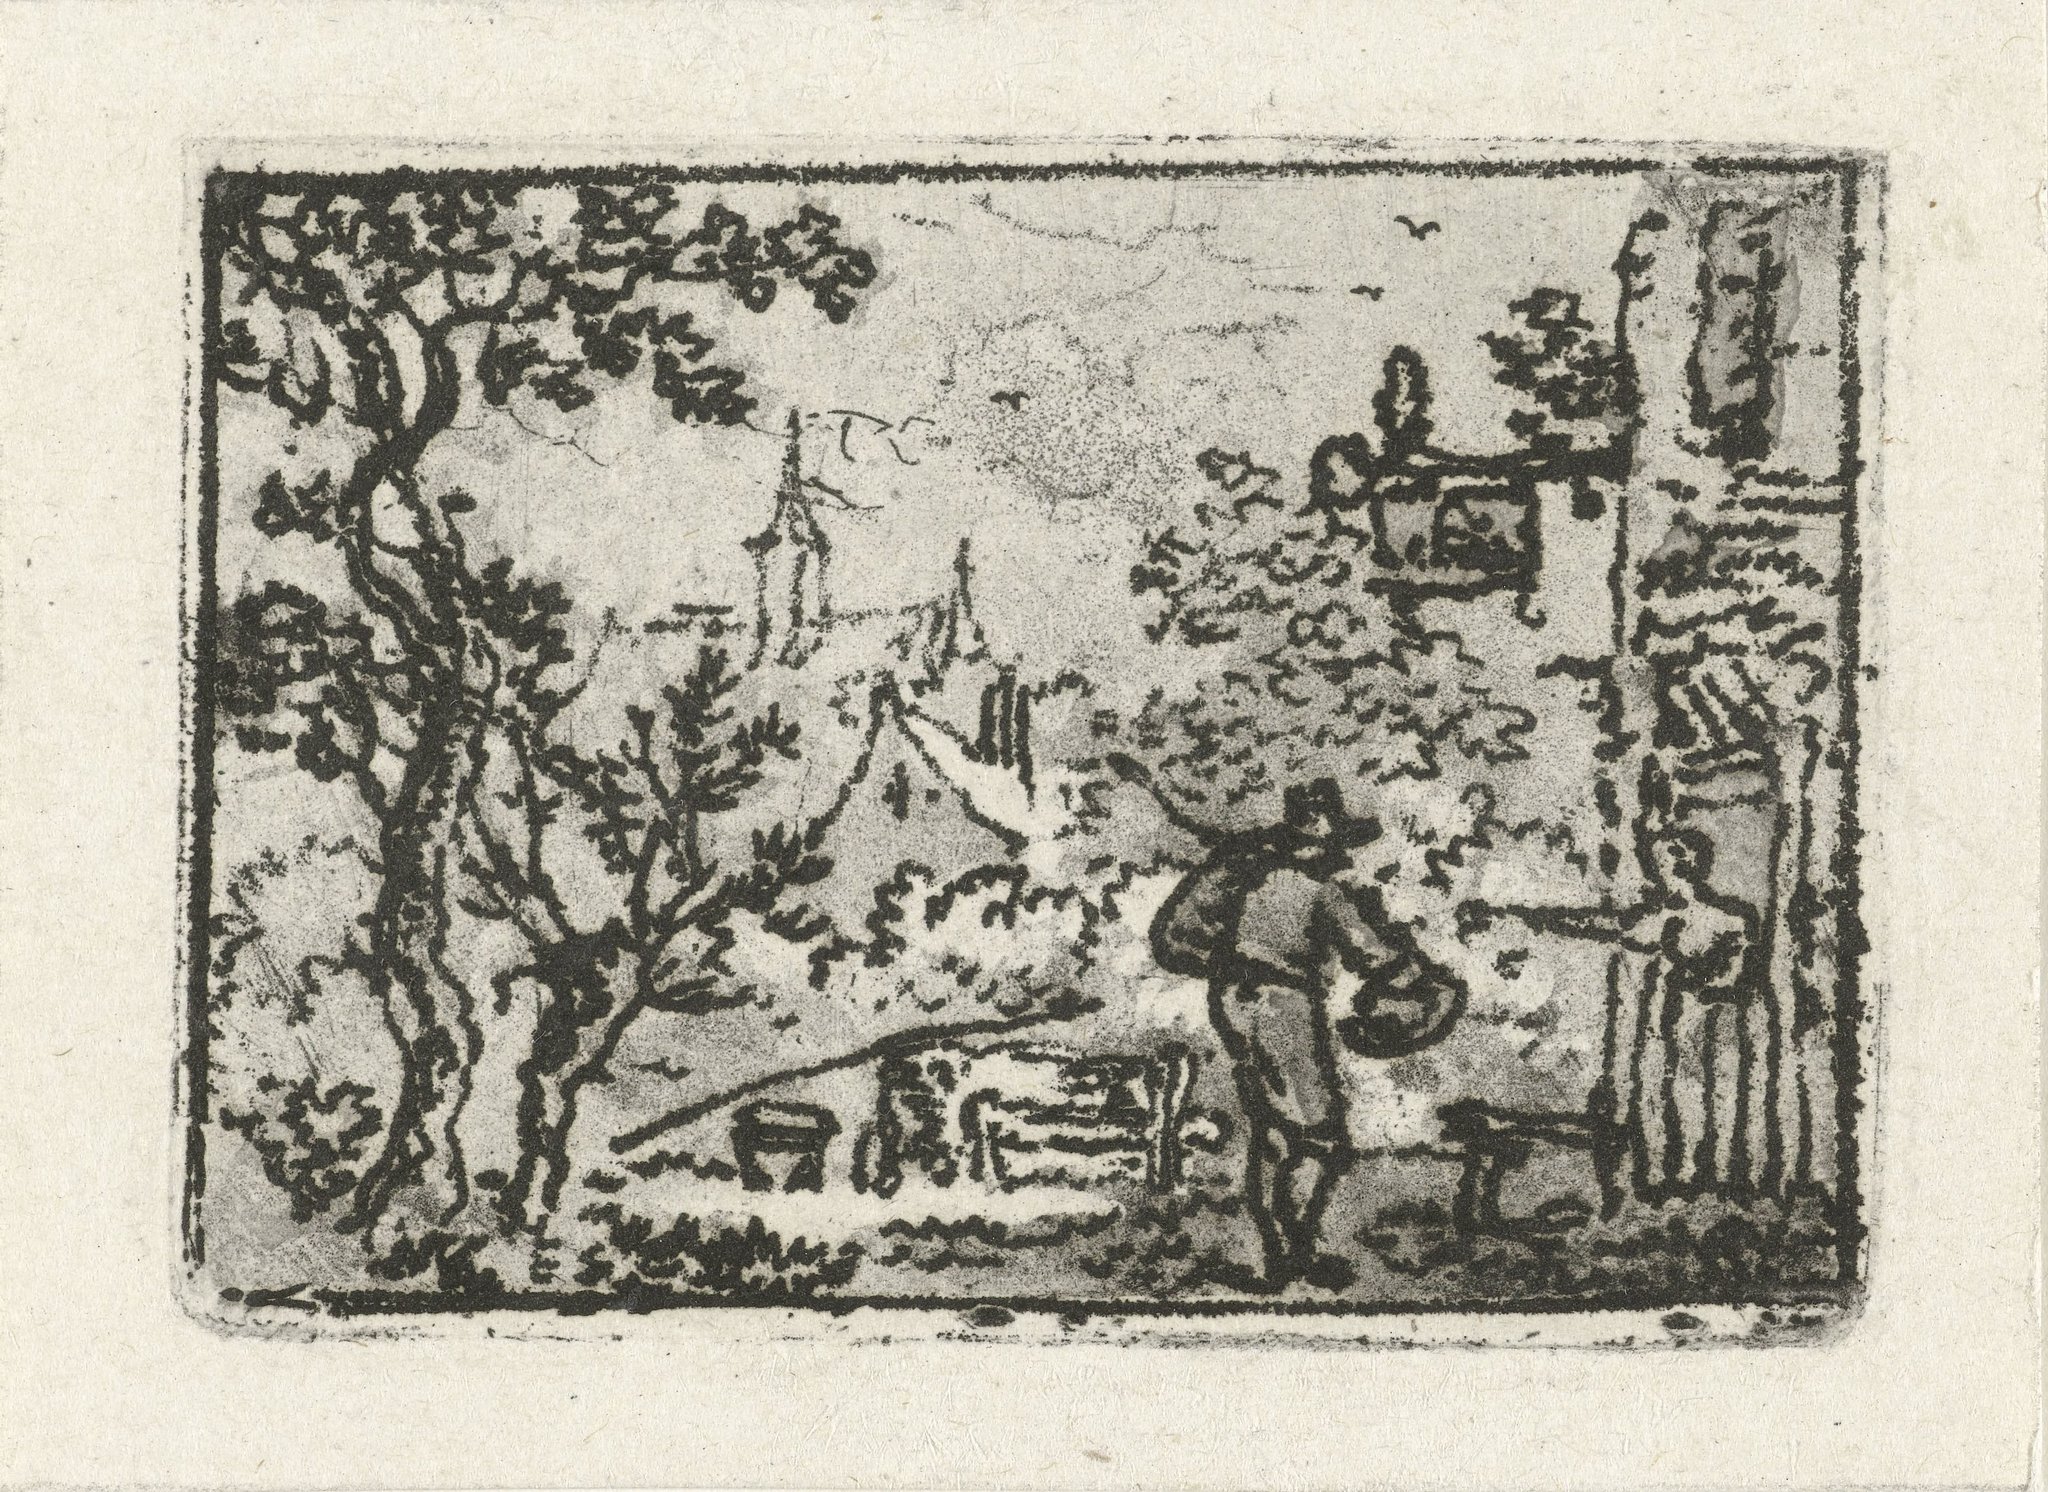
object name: print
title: Dorpsgezicht met voetganger bij vrouw in deur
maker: hermanus fock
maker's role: conservator, draughtsman, painter, print maker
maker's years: 1766-1822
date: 1781-1822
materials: paper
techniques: aquatint, etching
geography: amsterdam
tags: village (+ city(-scape) with figures, staffage)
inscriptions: collector's mark: Lugt 2228